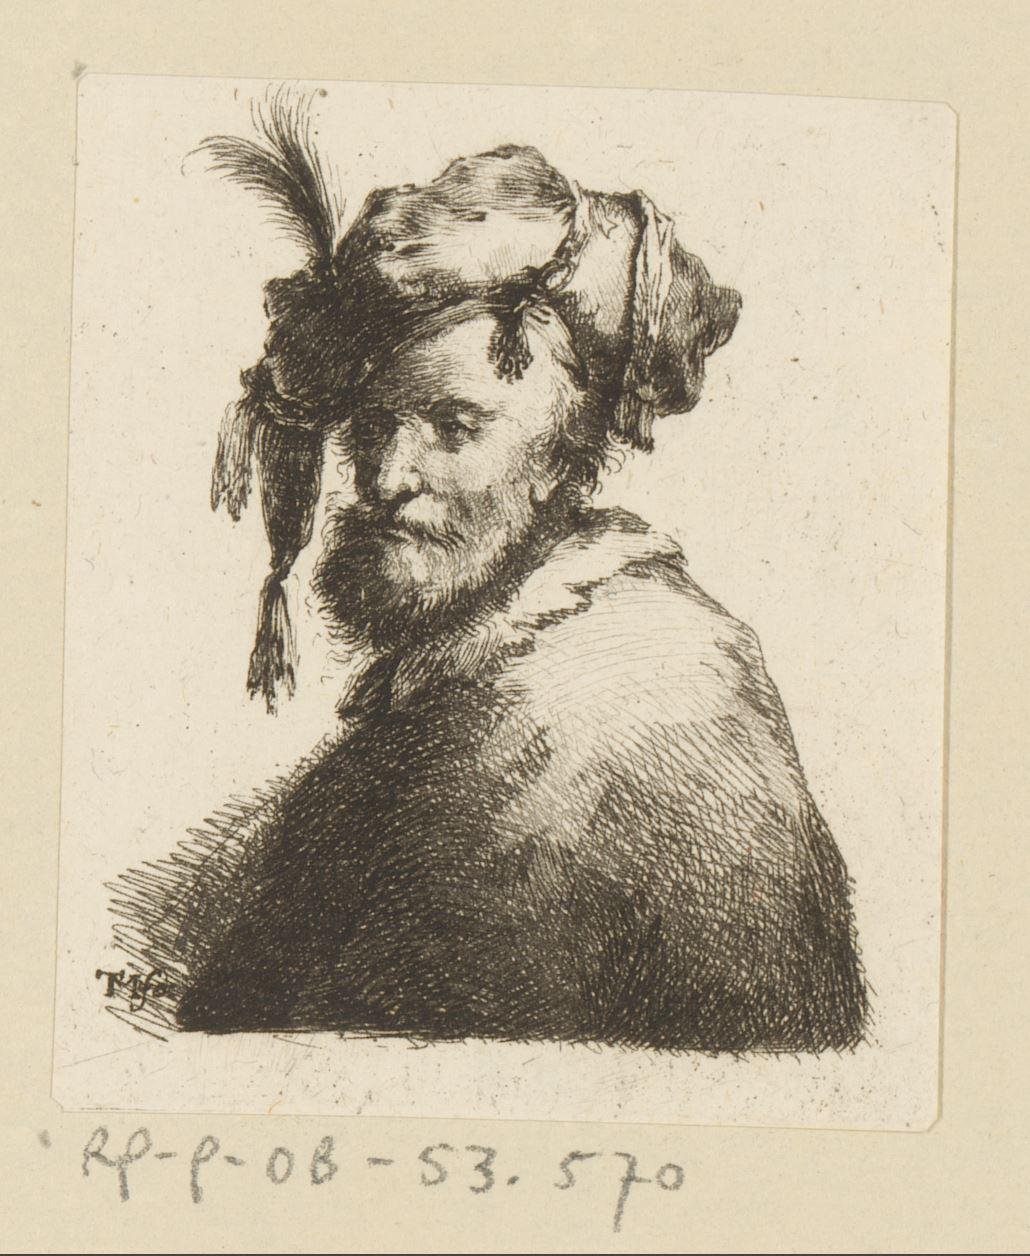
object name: print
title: Man met muts met afhangende punt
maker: johann georg trautmann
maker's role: draughtsman, painter, print maker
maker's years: 1713-1769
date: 1728-1769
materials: paper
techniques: etching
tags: head-gear: cap (+ men's clothes), old man, beard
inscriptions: collector's mark: Lugt 240